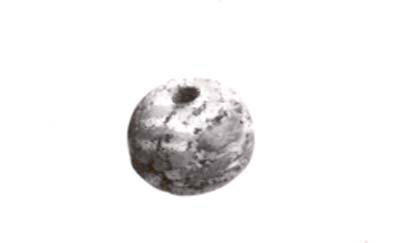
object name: bead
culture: sasanian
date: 201-700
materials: glass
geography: iran